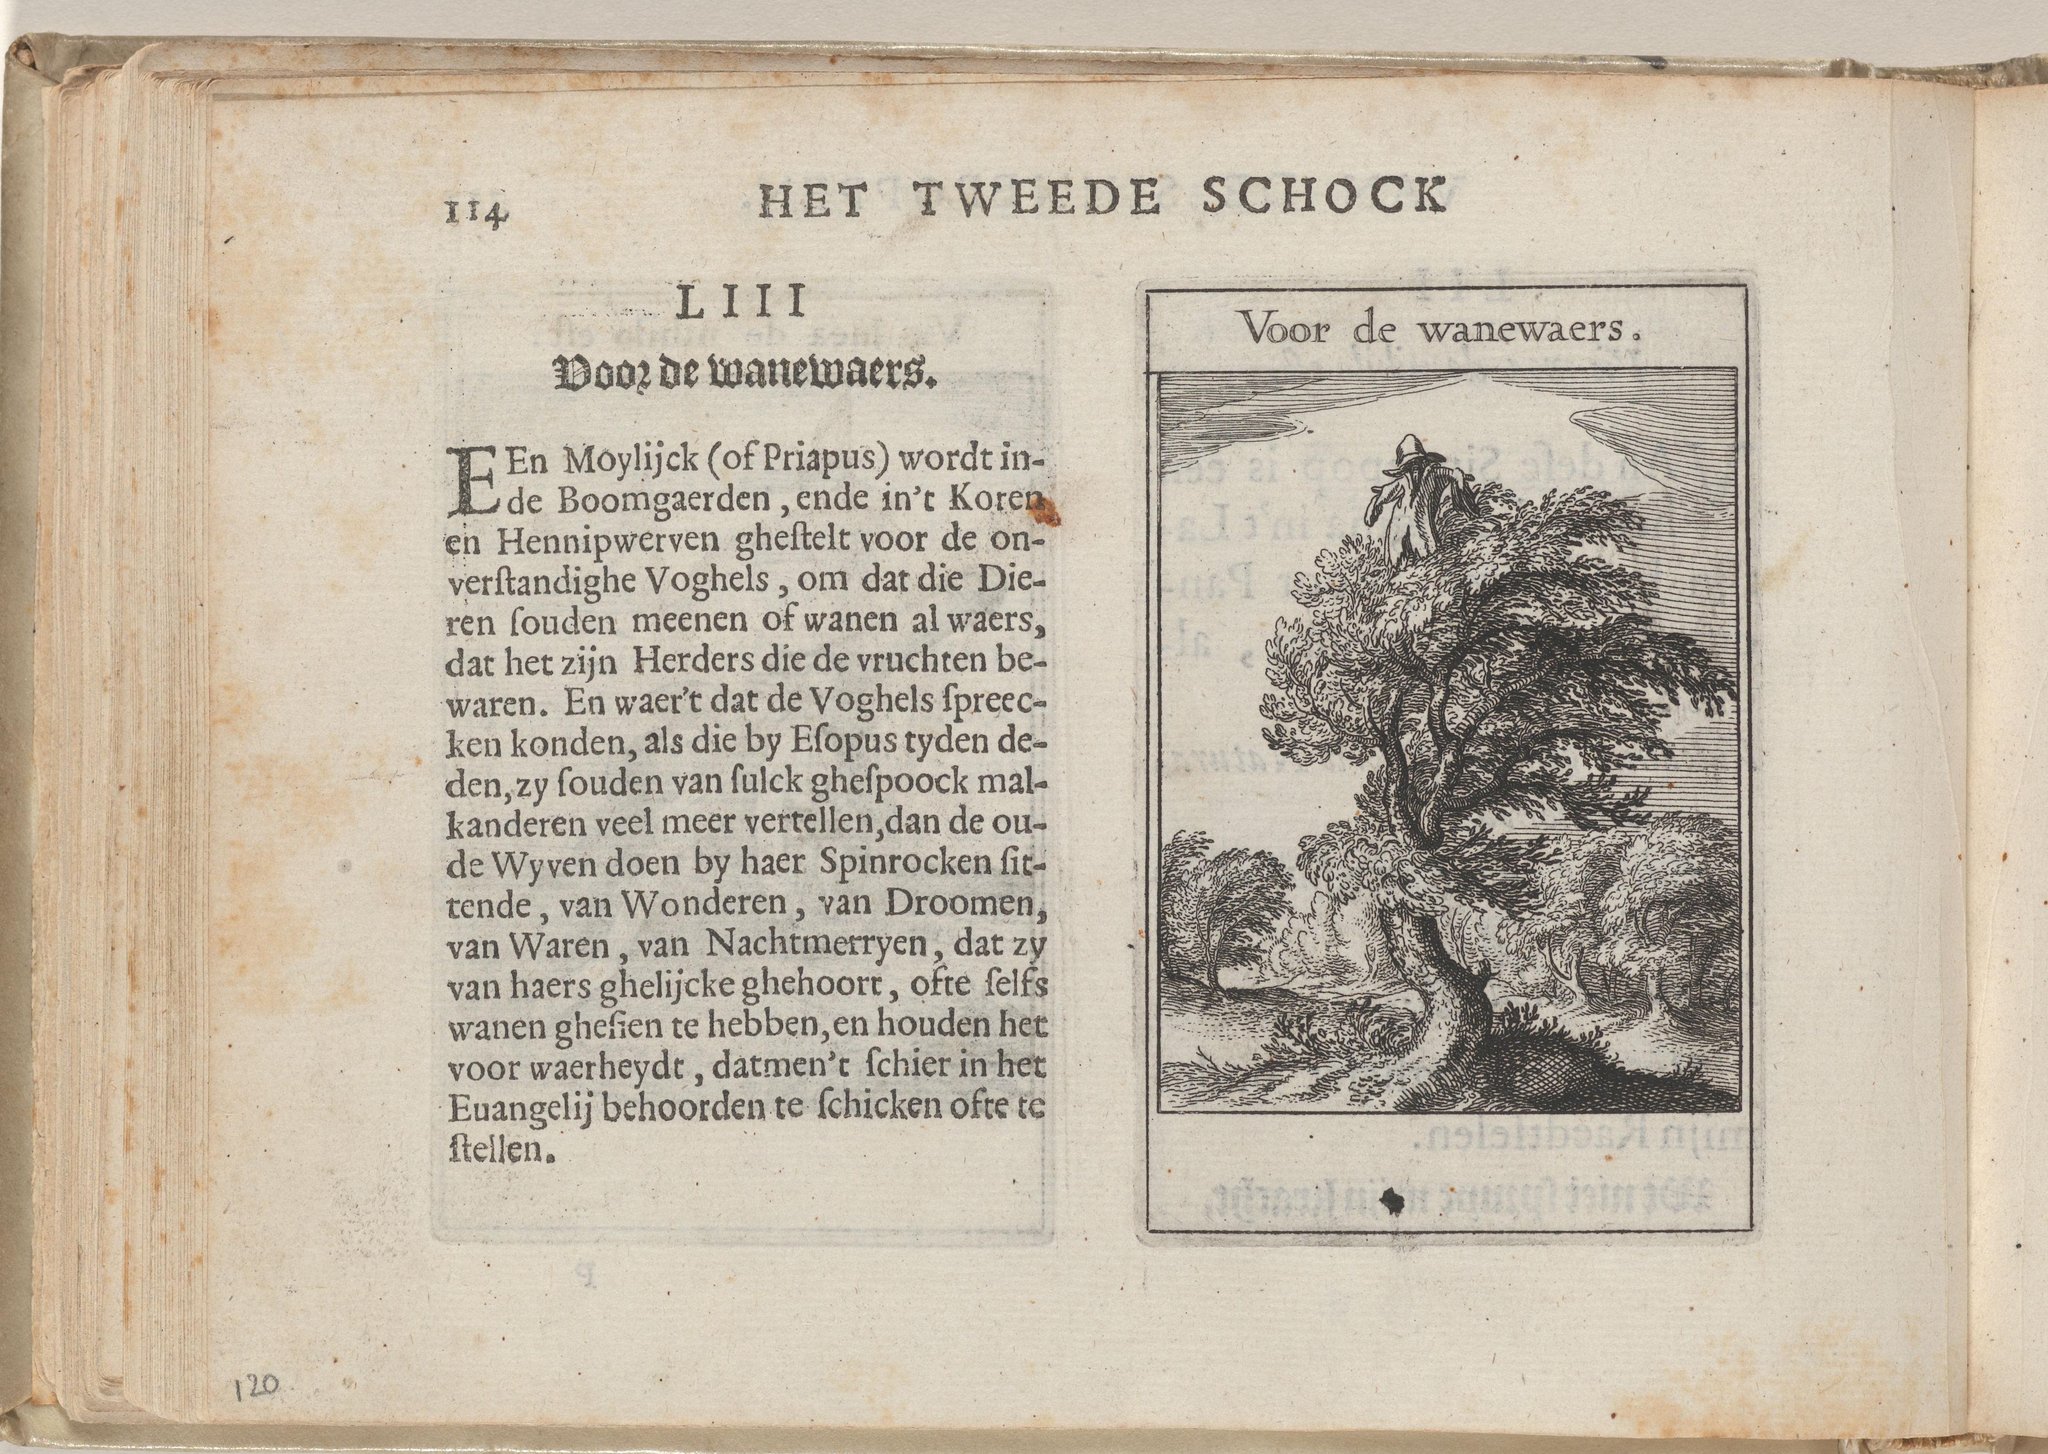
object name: print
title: LIII Voor de wanewaers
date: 1614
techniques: engraving, printing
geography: the hague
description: LIII Voor de wanewaers. Tweede schok. Onderdeel van 'Sinnepoppen', R. Visscher, 1614.